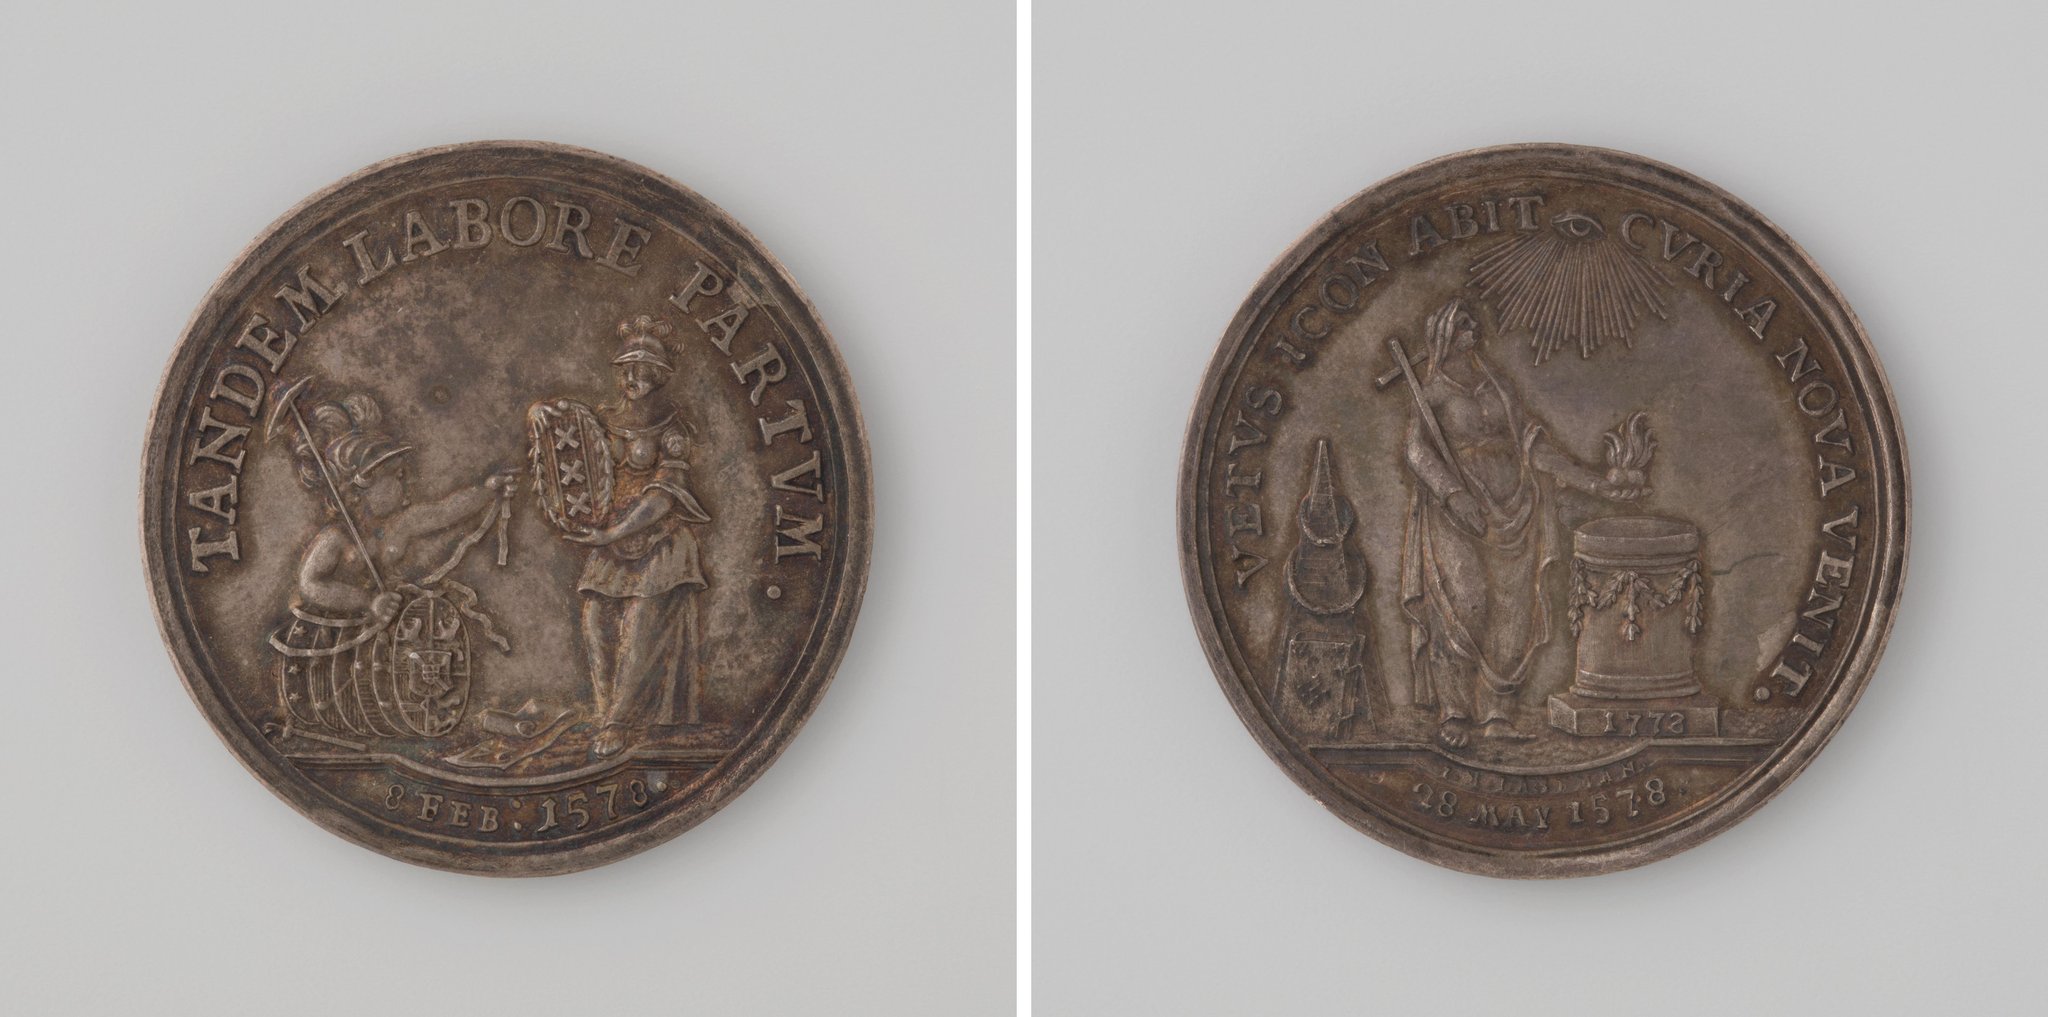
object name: history medal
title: Tweede eeuwfeest van de toetreding van Amsterdam tot de Unie van Utrecht en de invoering van de kerkhervorming aldaar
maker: johannes michiel lageman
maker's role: silversmith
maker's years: 1735-1809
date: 1778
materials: silver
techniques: striking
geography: amsterdam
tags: amsterdam, union of utrecht